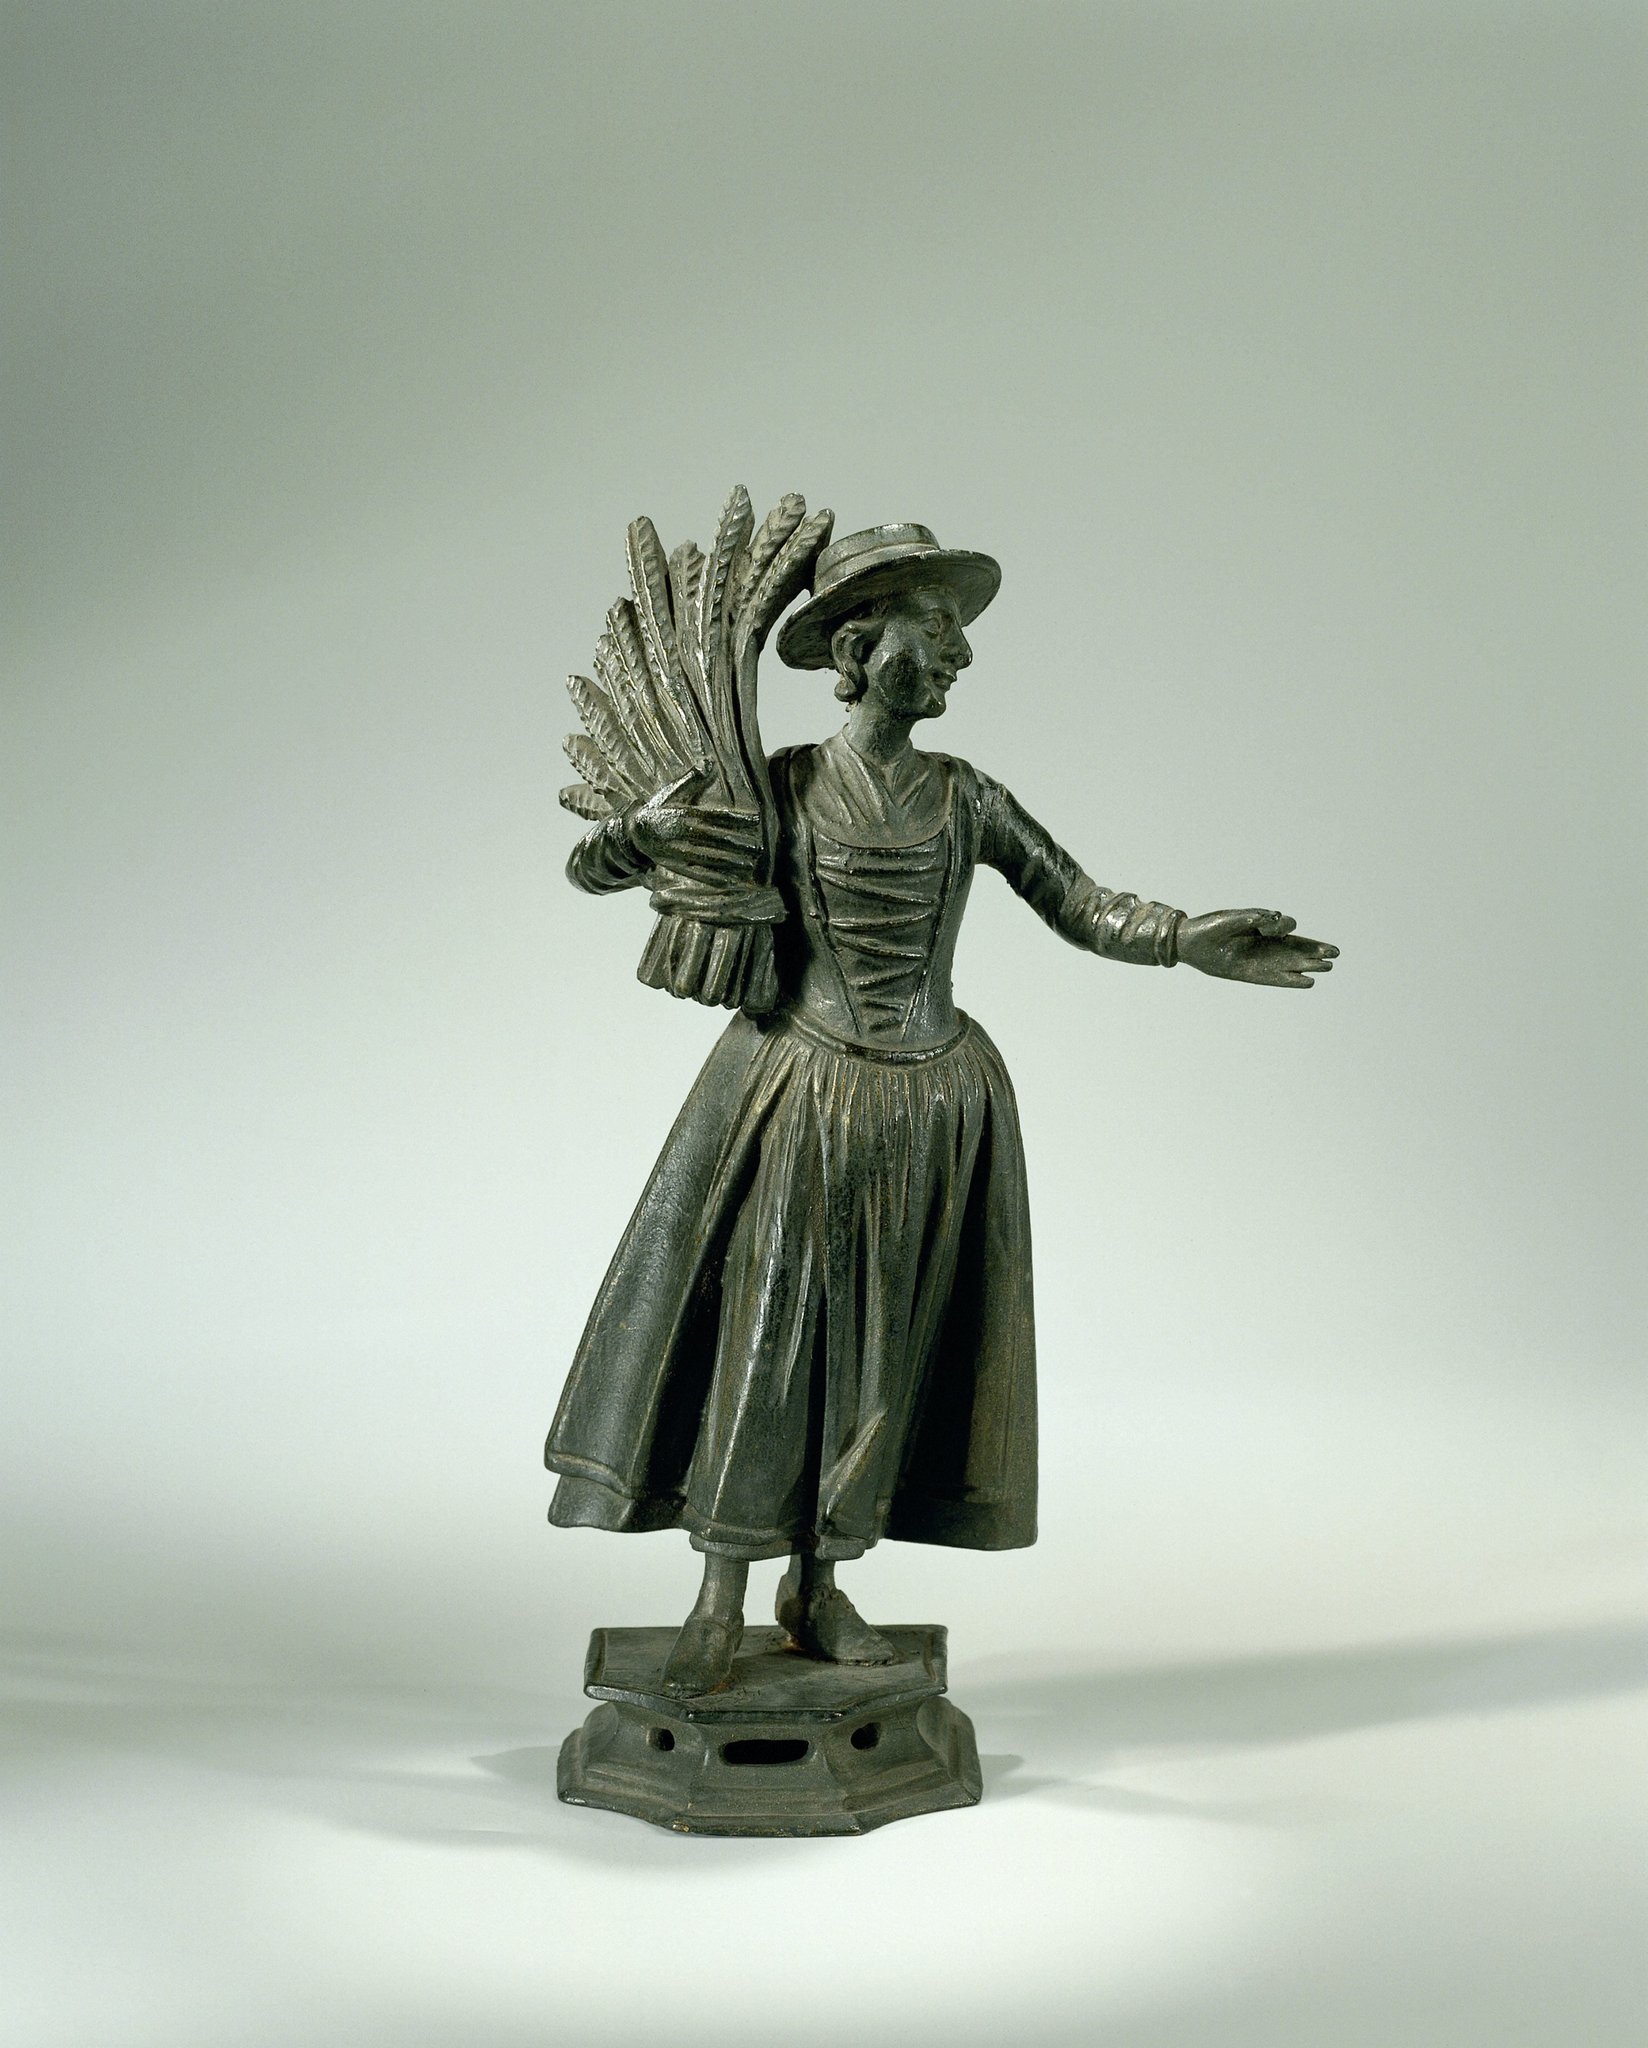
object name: sculpture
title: Figuur, voorstellende De Zomer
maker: Anonymous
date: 1700-1800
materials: wood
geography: oberammergau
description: Figuur, vrouw met korenschoof (De Zomer). Op een opengewerkt laag voetstuk.